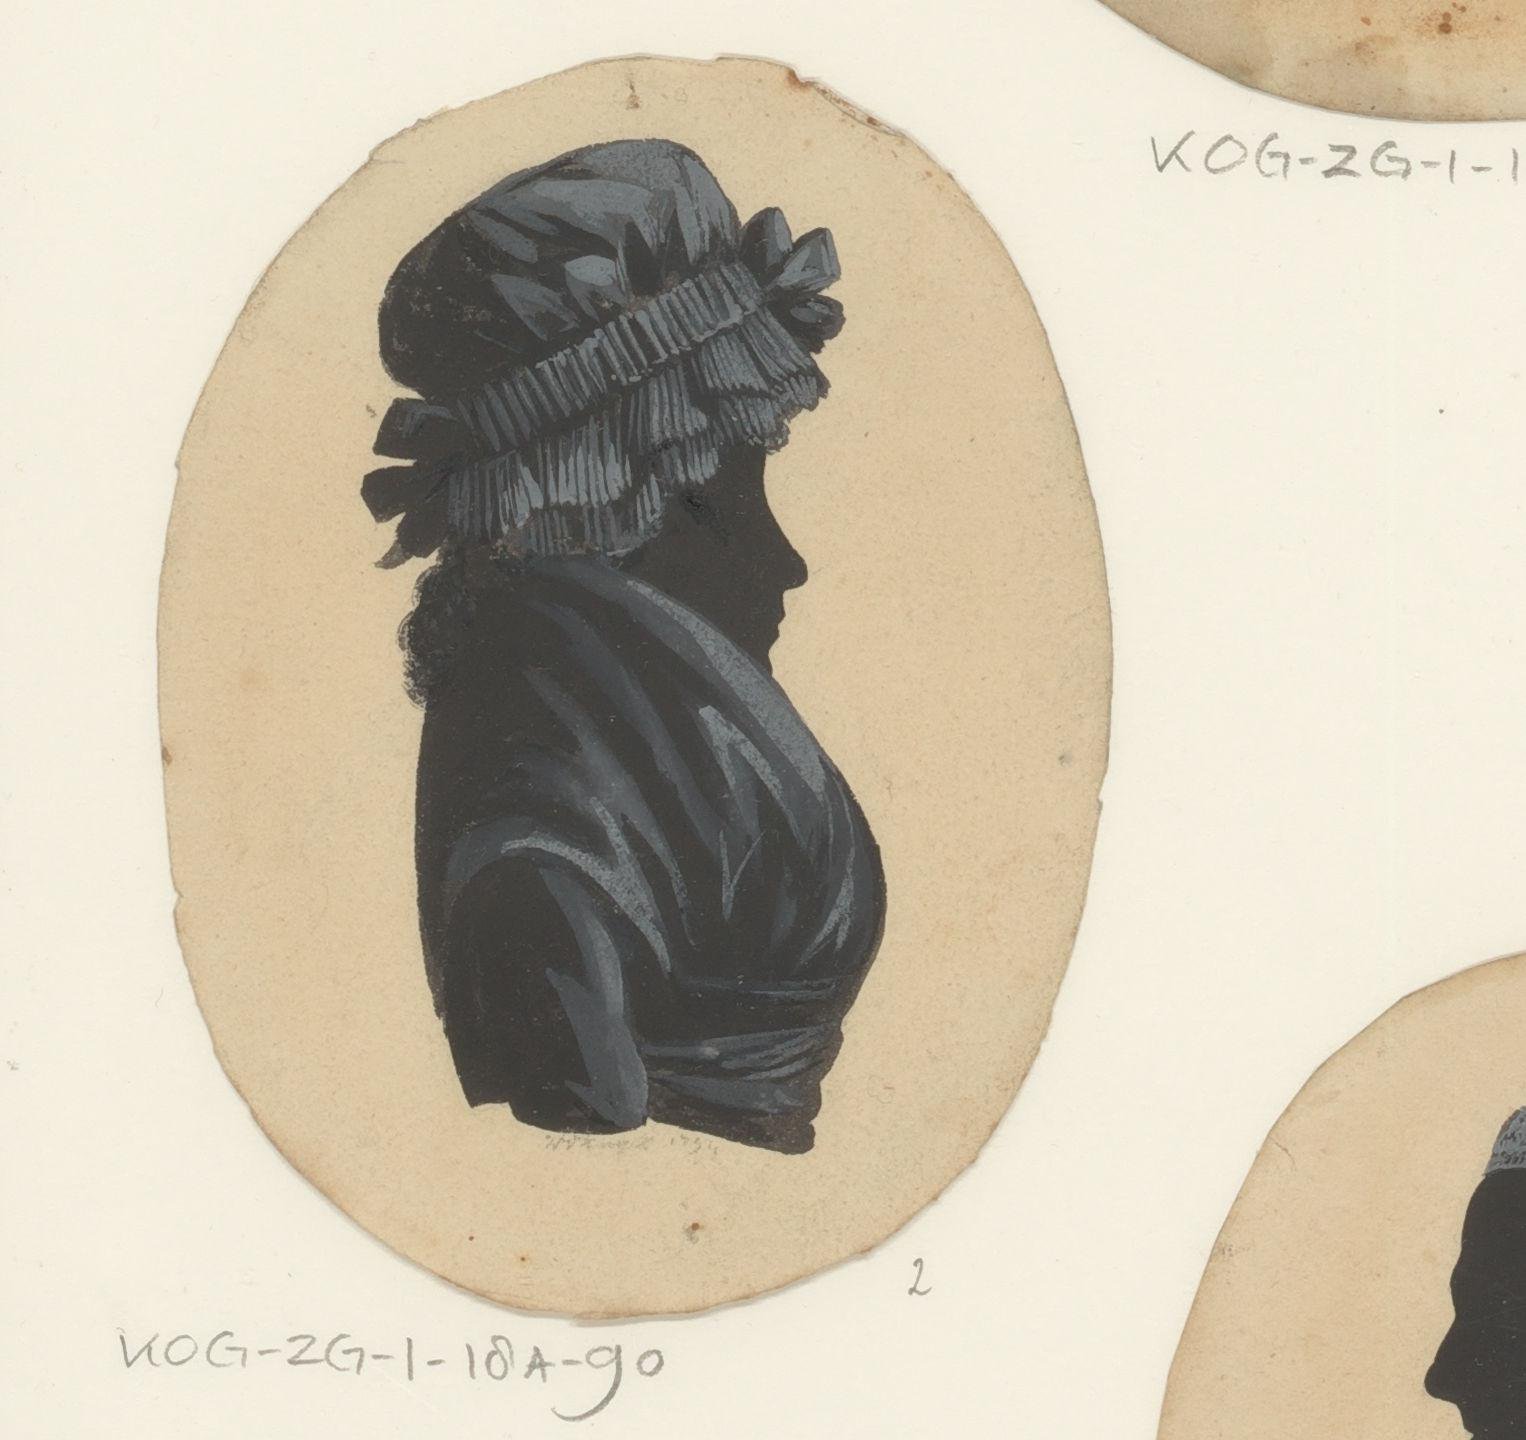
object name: drawing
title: Silhouetportret van een onbekende vrouw met muts met franjes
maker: h. van kuyk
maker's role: draughtsman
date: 1794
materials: paint, paper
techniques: brush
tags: historical persons not known by name - bb - woman, old woman, head-gear: cap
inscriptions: collector's mark: Lugt 1641, stamp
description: Silhouetportret van een onbekende vrouw met muts met twee strikken en een dubbele, geplooide rand. Onderwerpsrubrieken binnen de Atlas Zeden en Gewoonten: Schoone kunsten, Silhouetportretten.